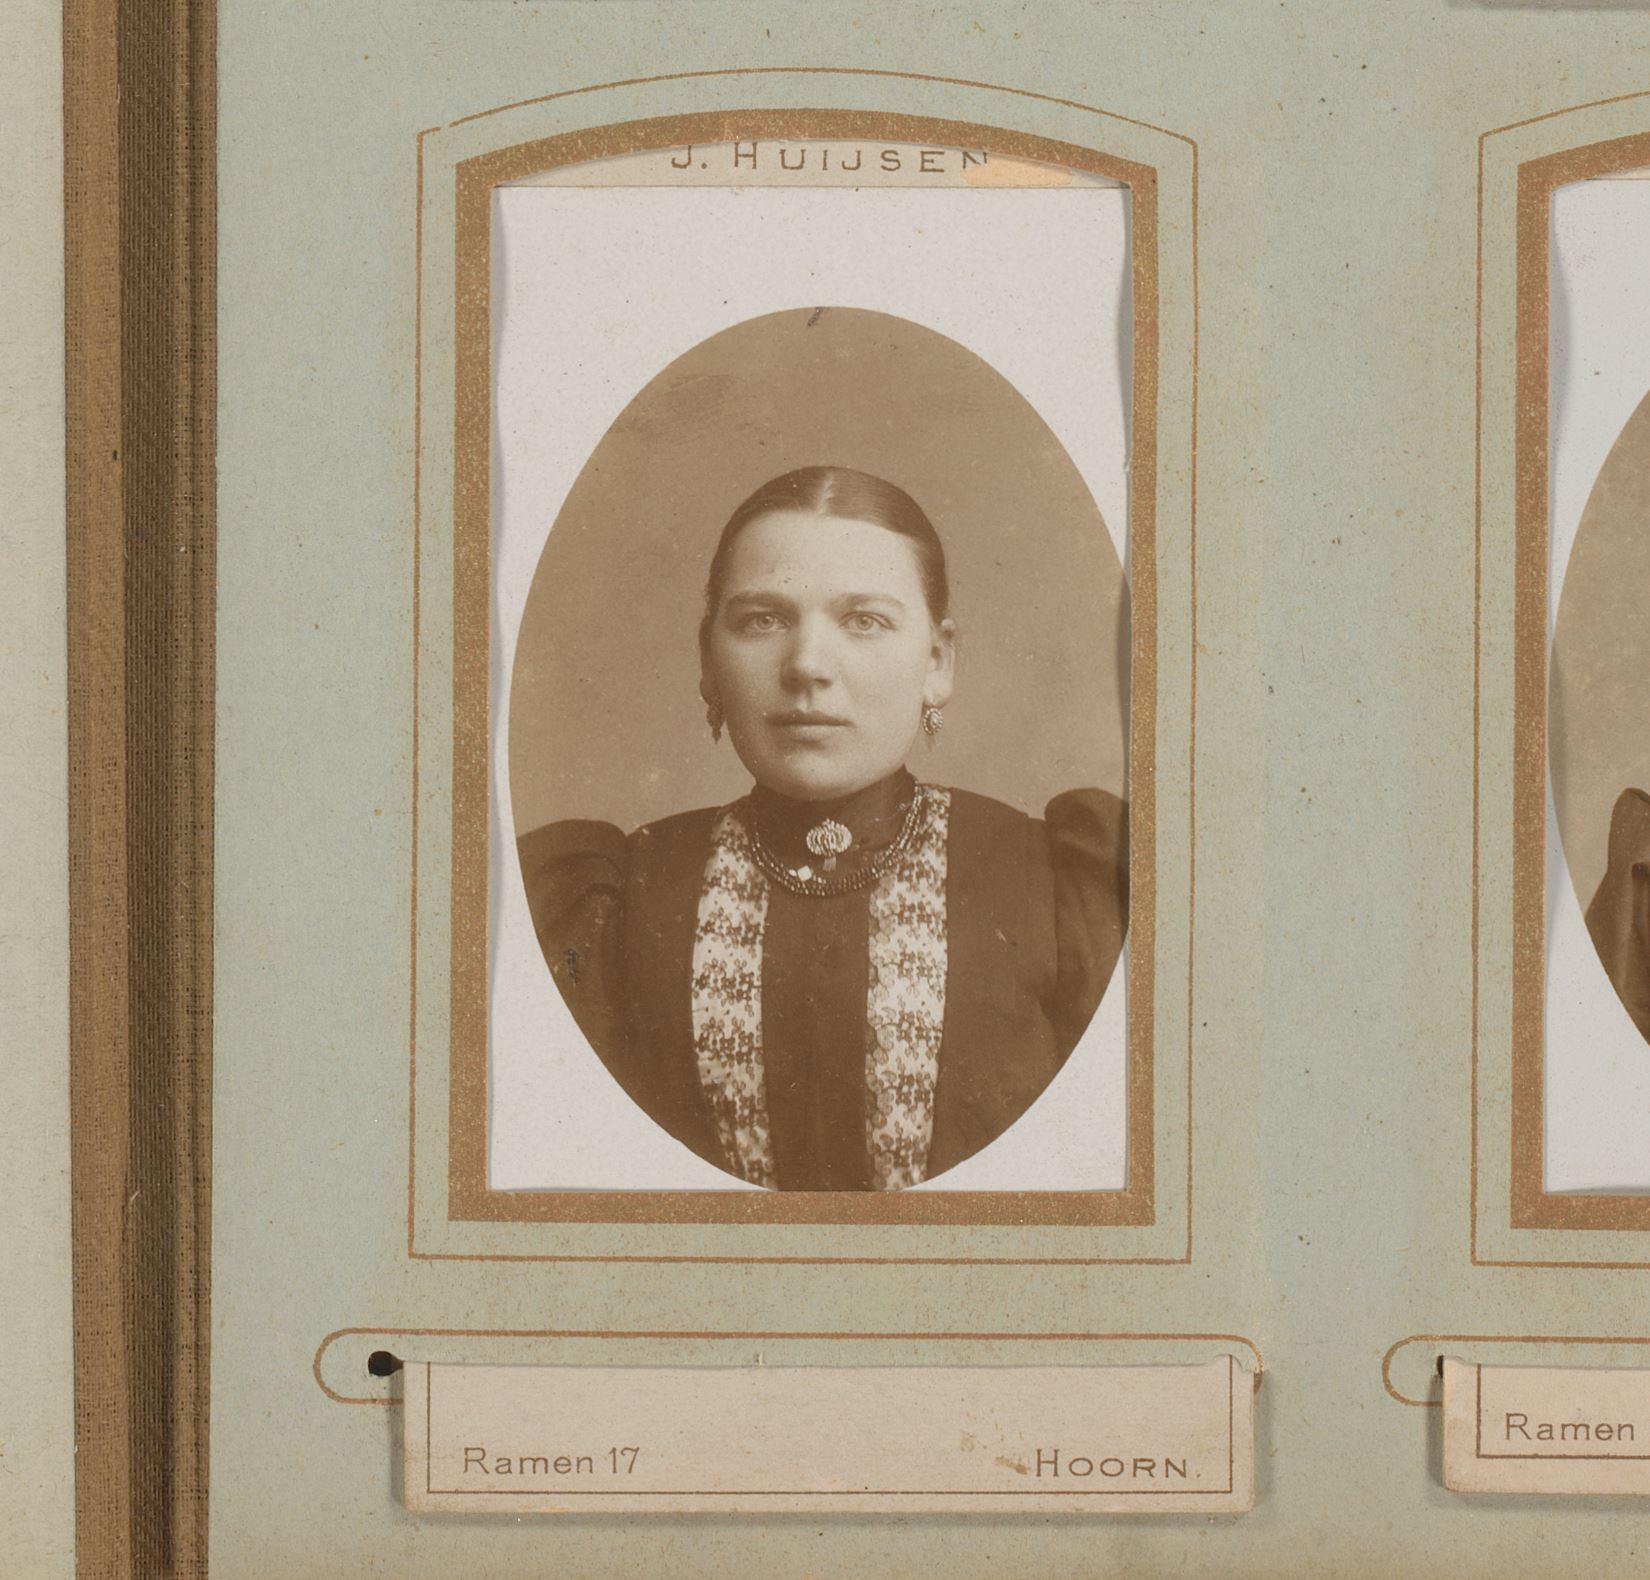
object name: carte de visite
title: Portret van een vrouw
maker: johannes laurens theodorus huijsen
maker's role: fotograaf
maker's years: 1852-1910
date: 1883-1910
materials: cardboard, photographic support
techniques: collodion silver print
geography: hoorn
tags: historical persons - bb - woman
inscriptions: inscription: ‘J.L.T. HUIJSEN/ Photographe/ Bekroond op verschillende/ Tentoonstellingen/ HOORN/ Ramen 17./ De plaat blijft ter nabestelling bewaard.’